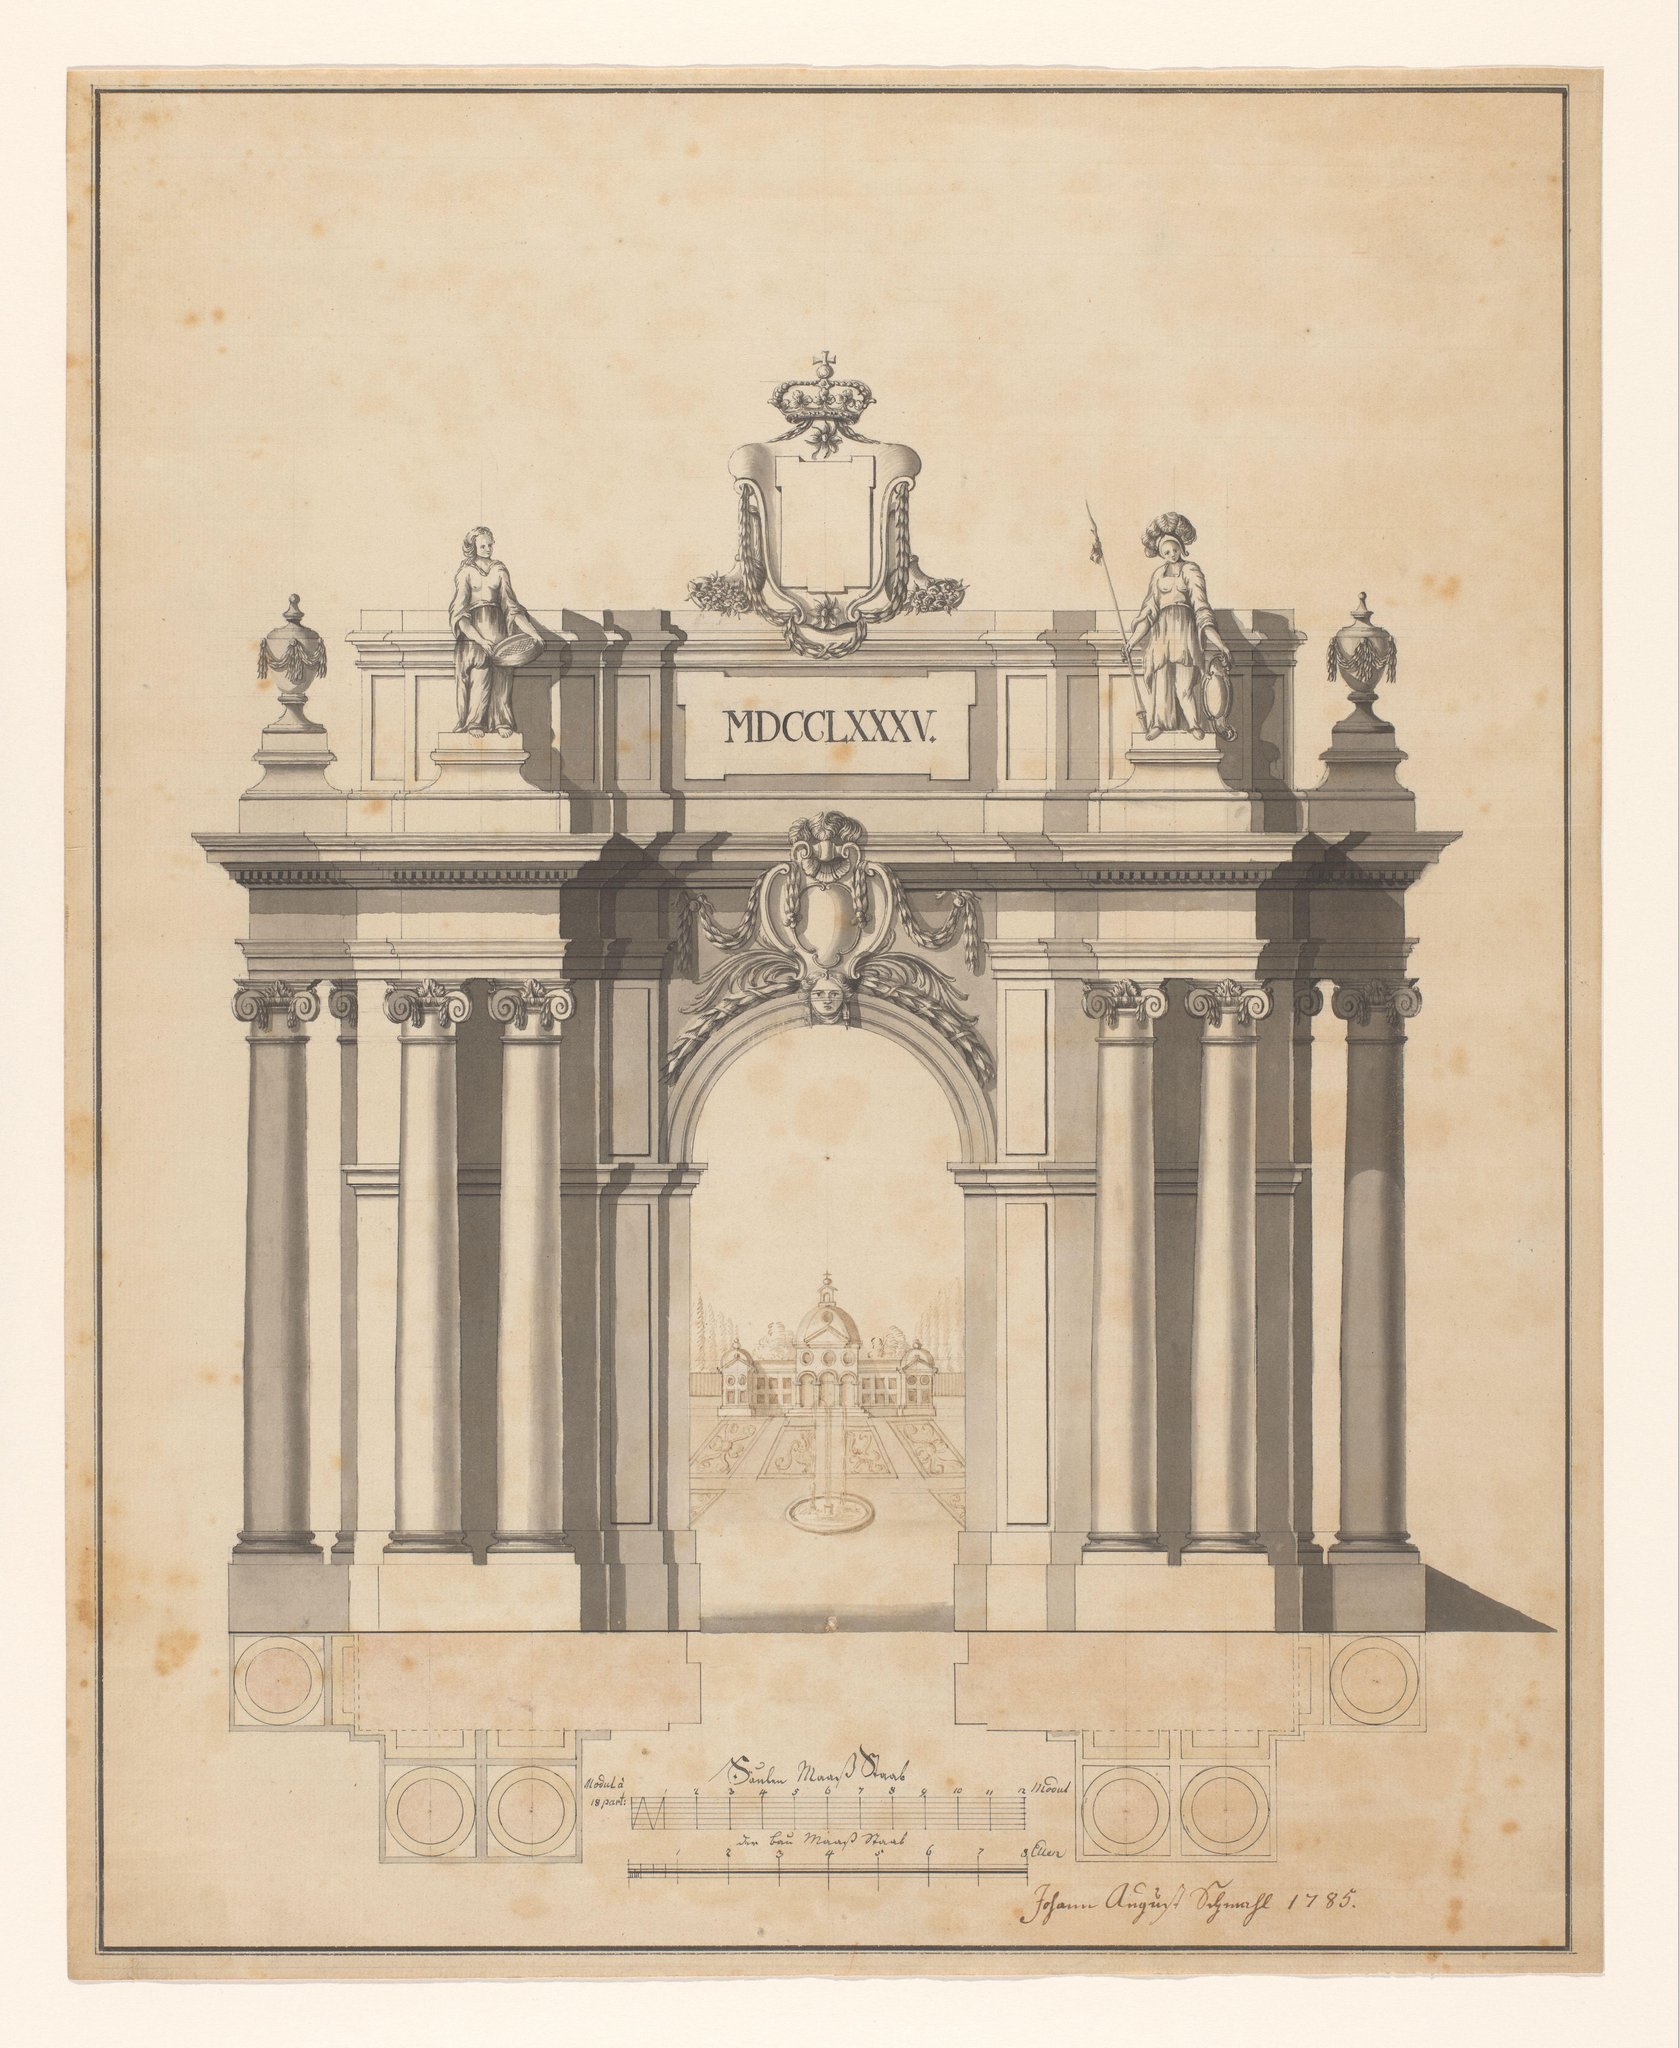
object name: drawing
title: Ontwerp voor een poort voor een tuin met een paviljoen, met eronder een plattegrond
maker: johann august schmahl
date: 1785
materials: graphite, ink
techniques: drawing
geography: germany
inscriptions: inscription: ‘MDCCLXXXV’, watermark: ‘J HONIG / & / ZOONEN’, size: ‘Twee maatstaven met: Säulen Maass Staab / Modul à / 18 part: / 1 2 3 4 5 6 7 8 9 10 11 12 Modul / der bau Maass Staab 1 2 3 4 5 6 7 8 Ellen / Johann August Schmahl 1785.’, mark: ‘Contramerk: wapen met dubbele balk (Strasburg band) met daarboven een lelie, daaronder een bijenkorf en JH&Z.’